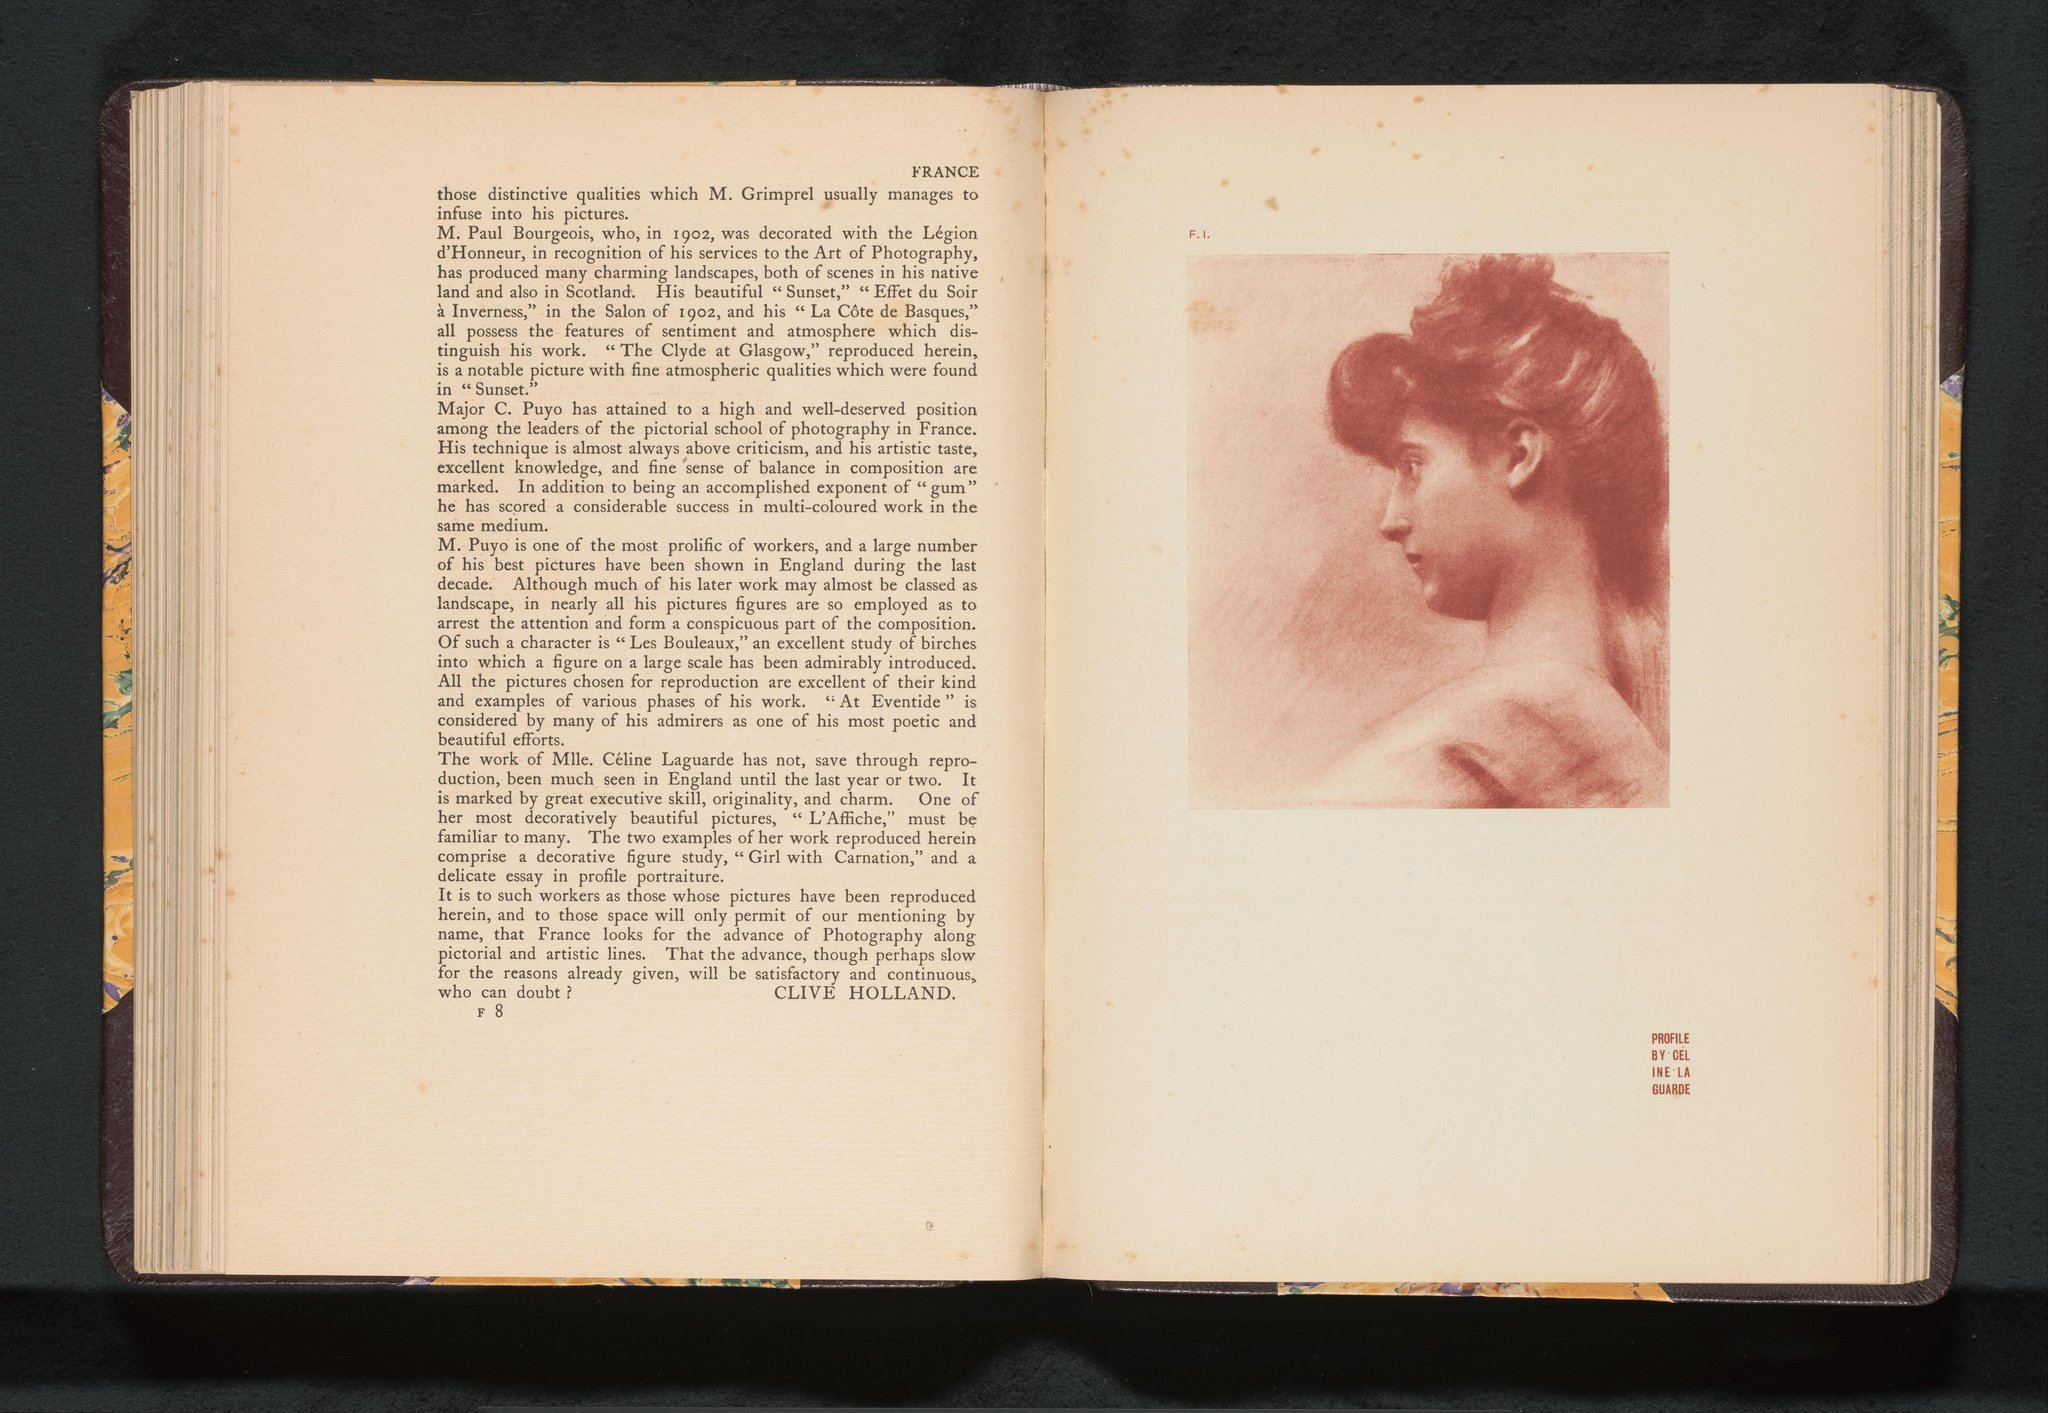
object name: page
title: Profiel van een jonge vrouw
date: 1900-1905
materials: paper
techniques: autotype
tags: the (nude) human figure; 'corpo humano' (ripa) (+ sideview, profile), historical persons - bb - woman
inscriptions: inscription: ‘Profile by Céline Laguarde’, inscription: ‘F. I.’